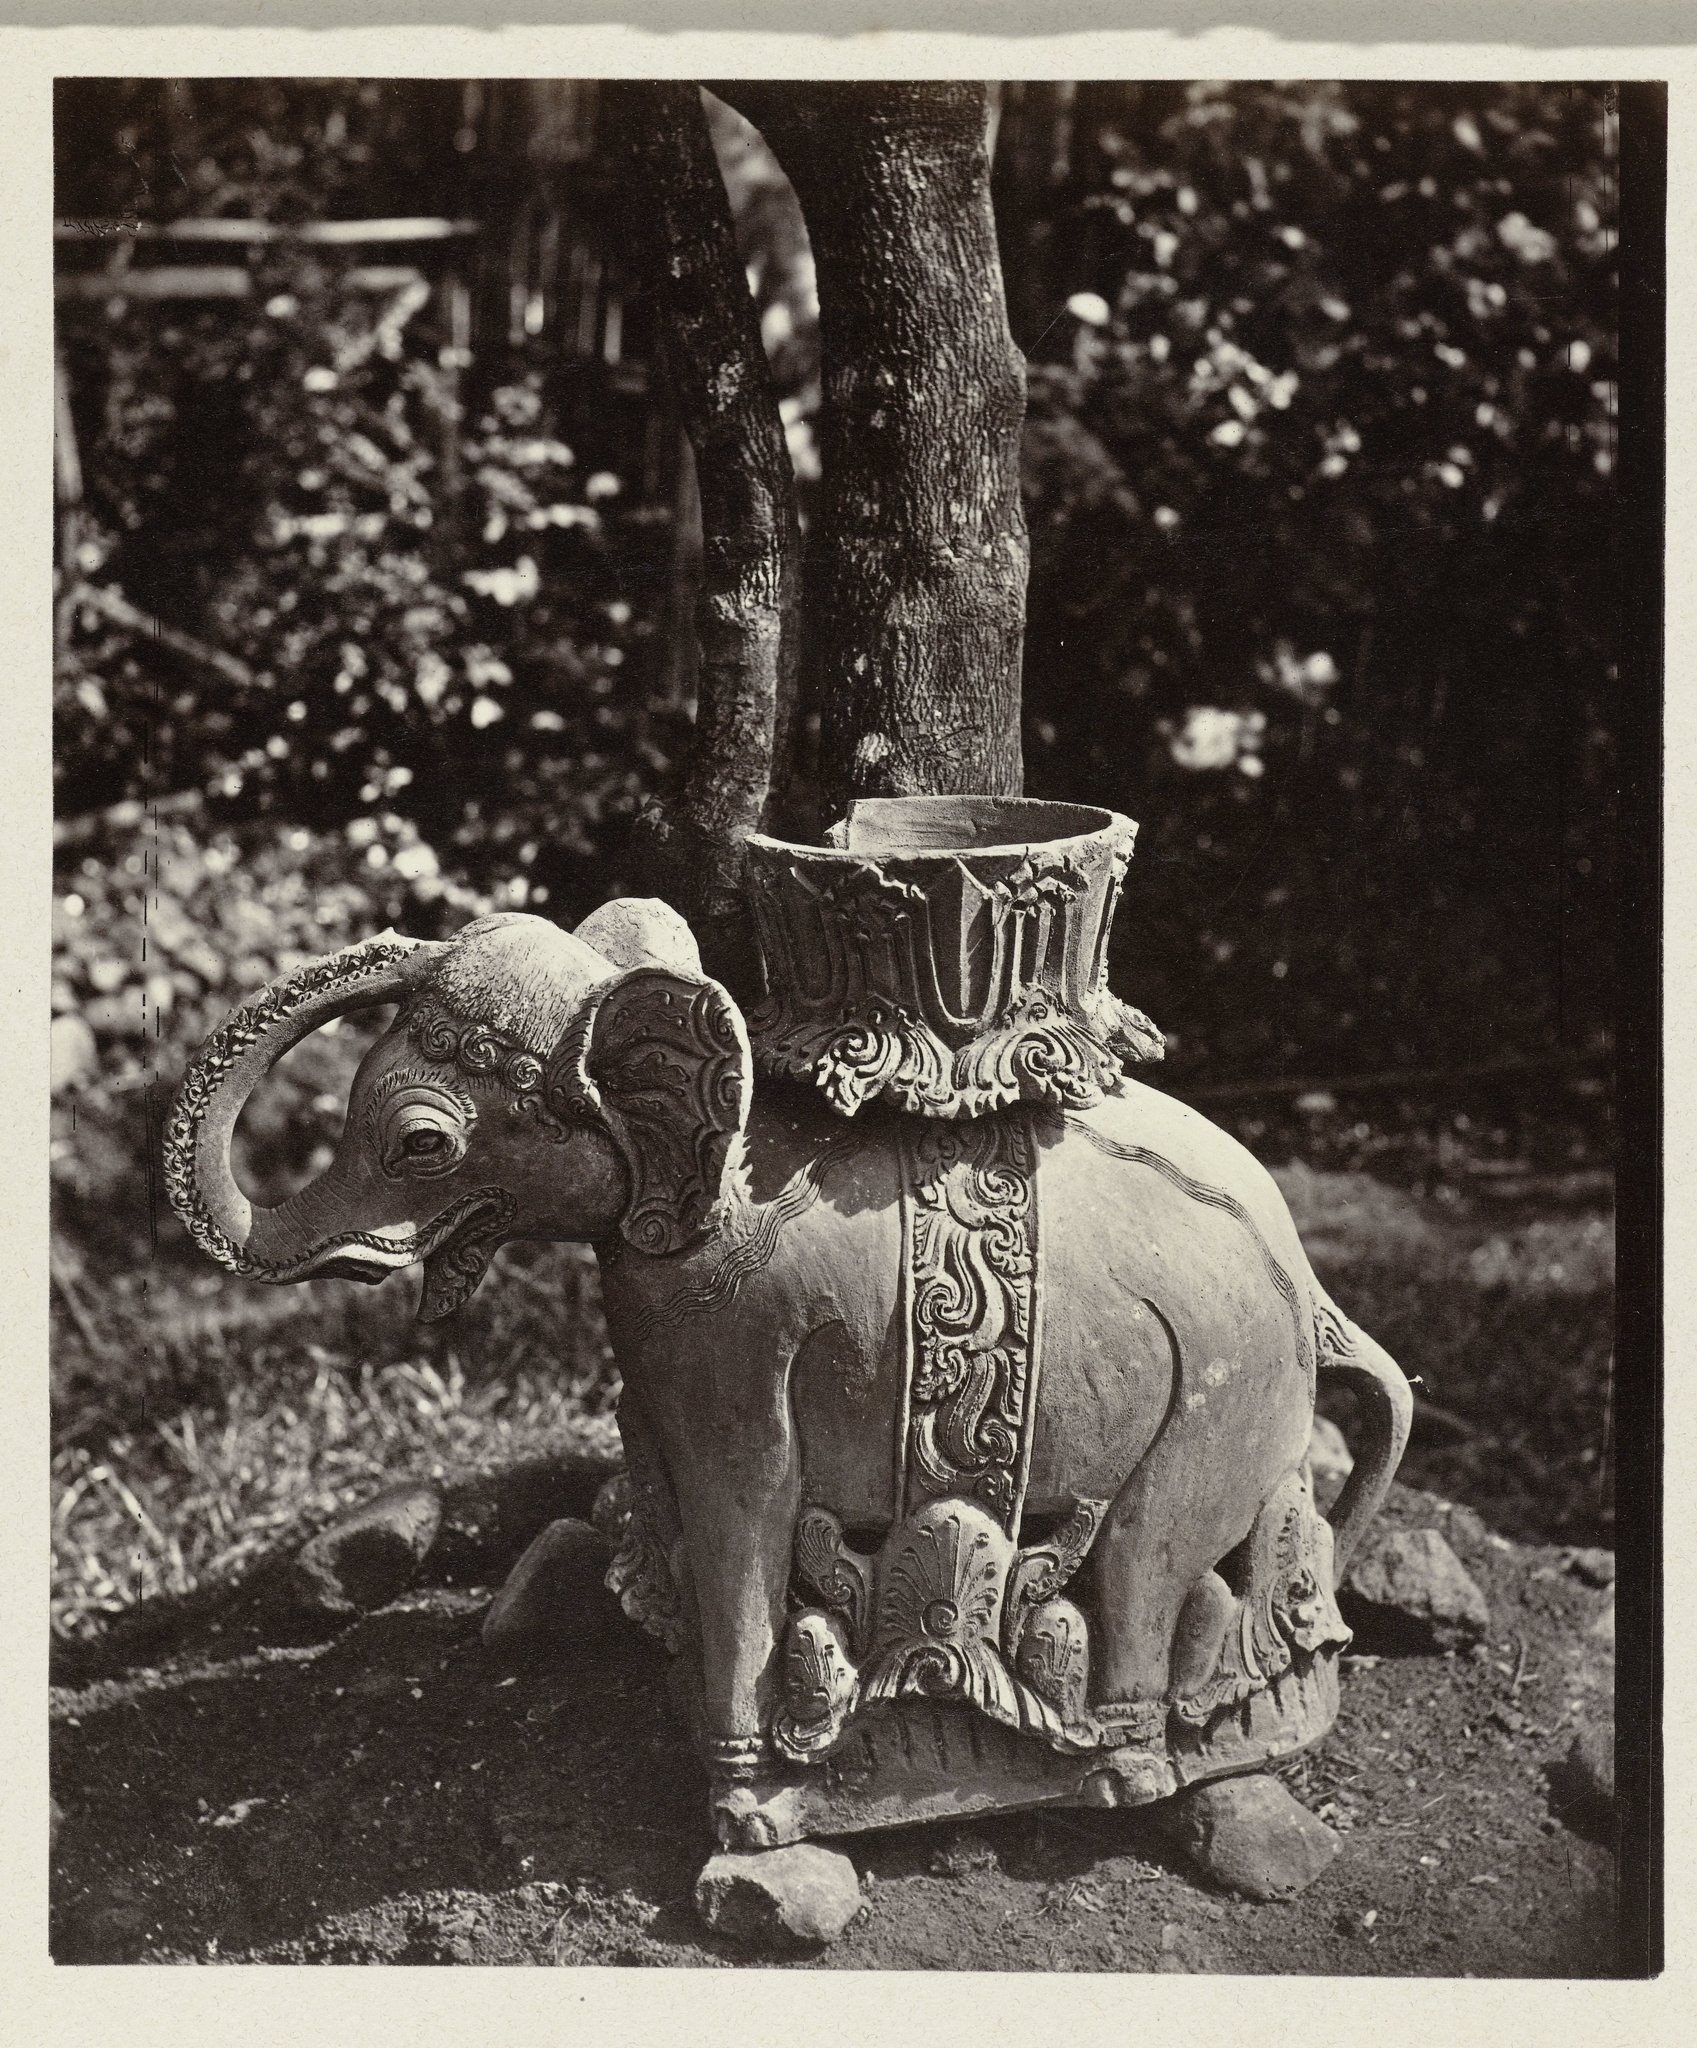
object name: photograph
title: Terra cotta elephant with depository Karta Wangingan, Kunigan district, West-Java province, period unknown.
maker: isidore kinsbergen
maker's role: fotograaf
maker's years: 1821-1905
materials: cardboard, paper, photographic support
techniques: albumen print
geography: java